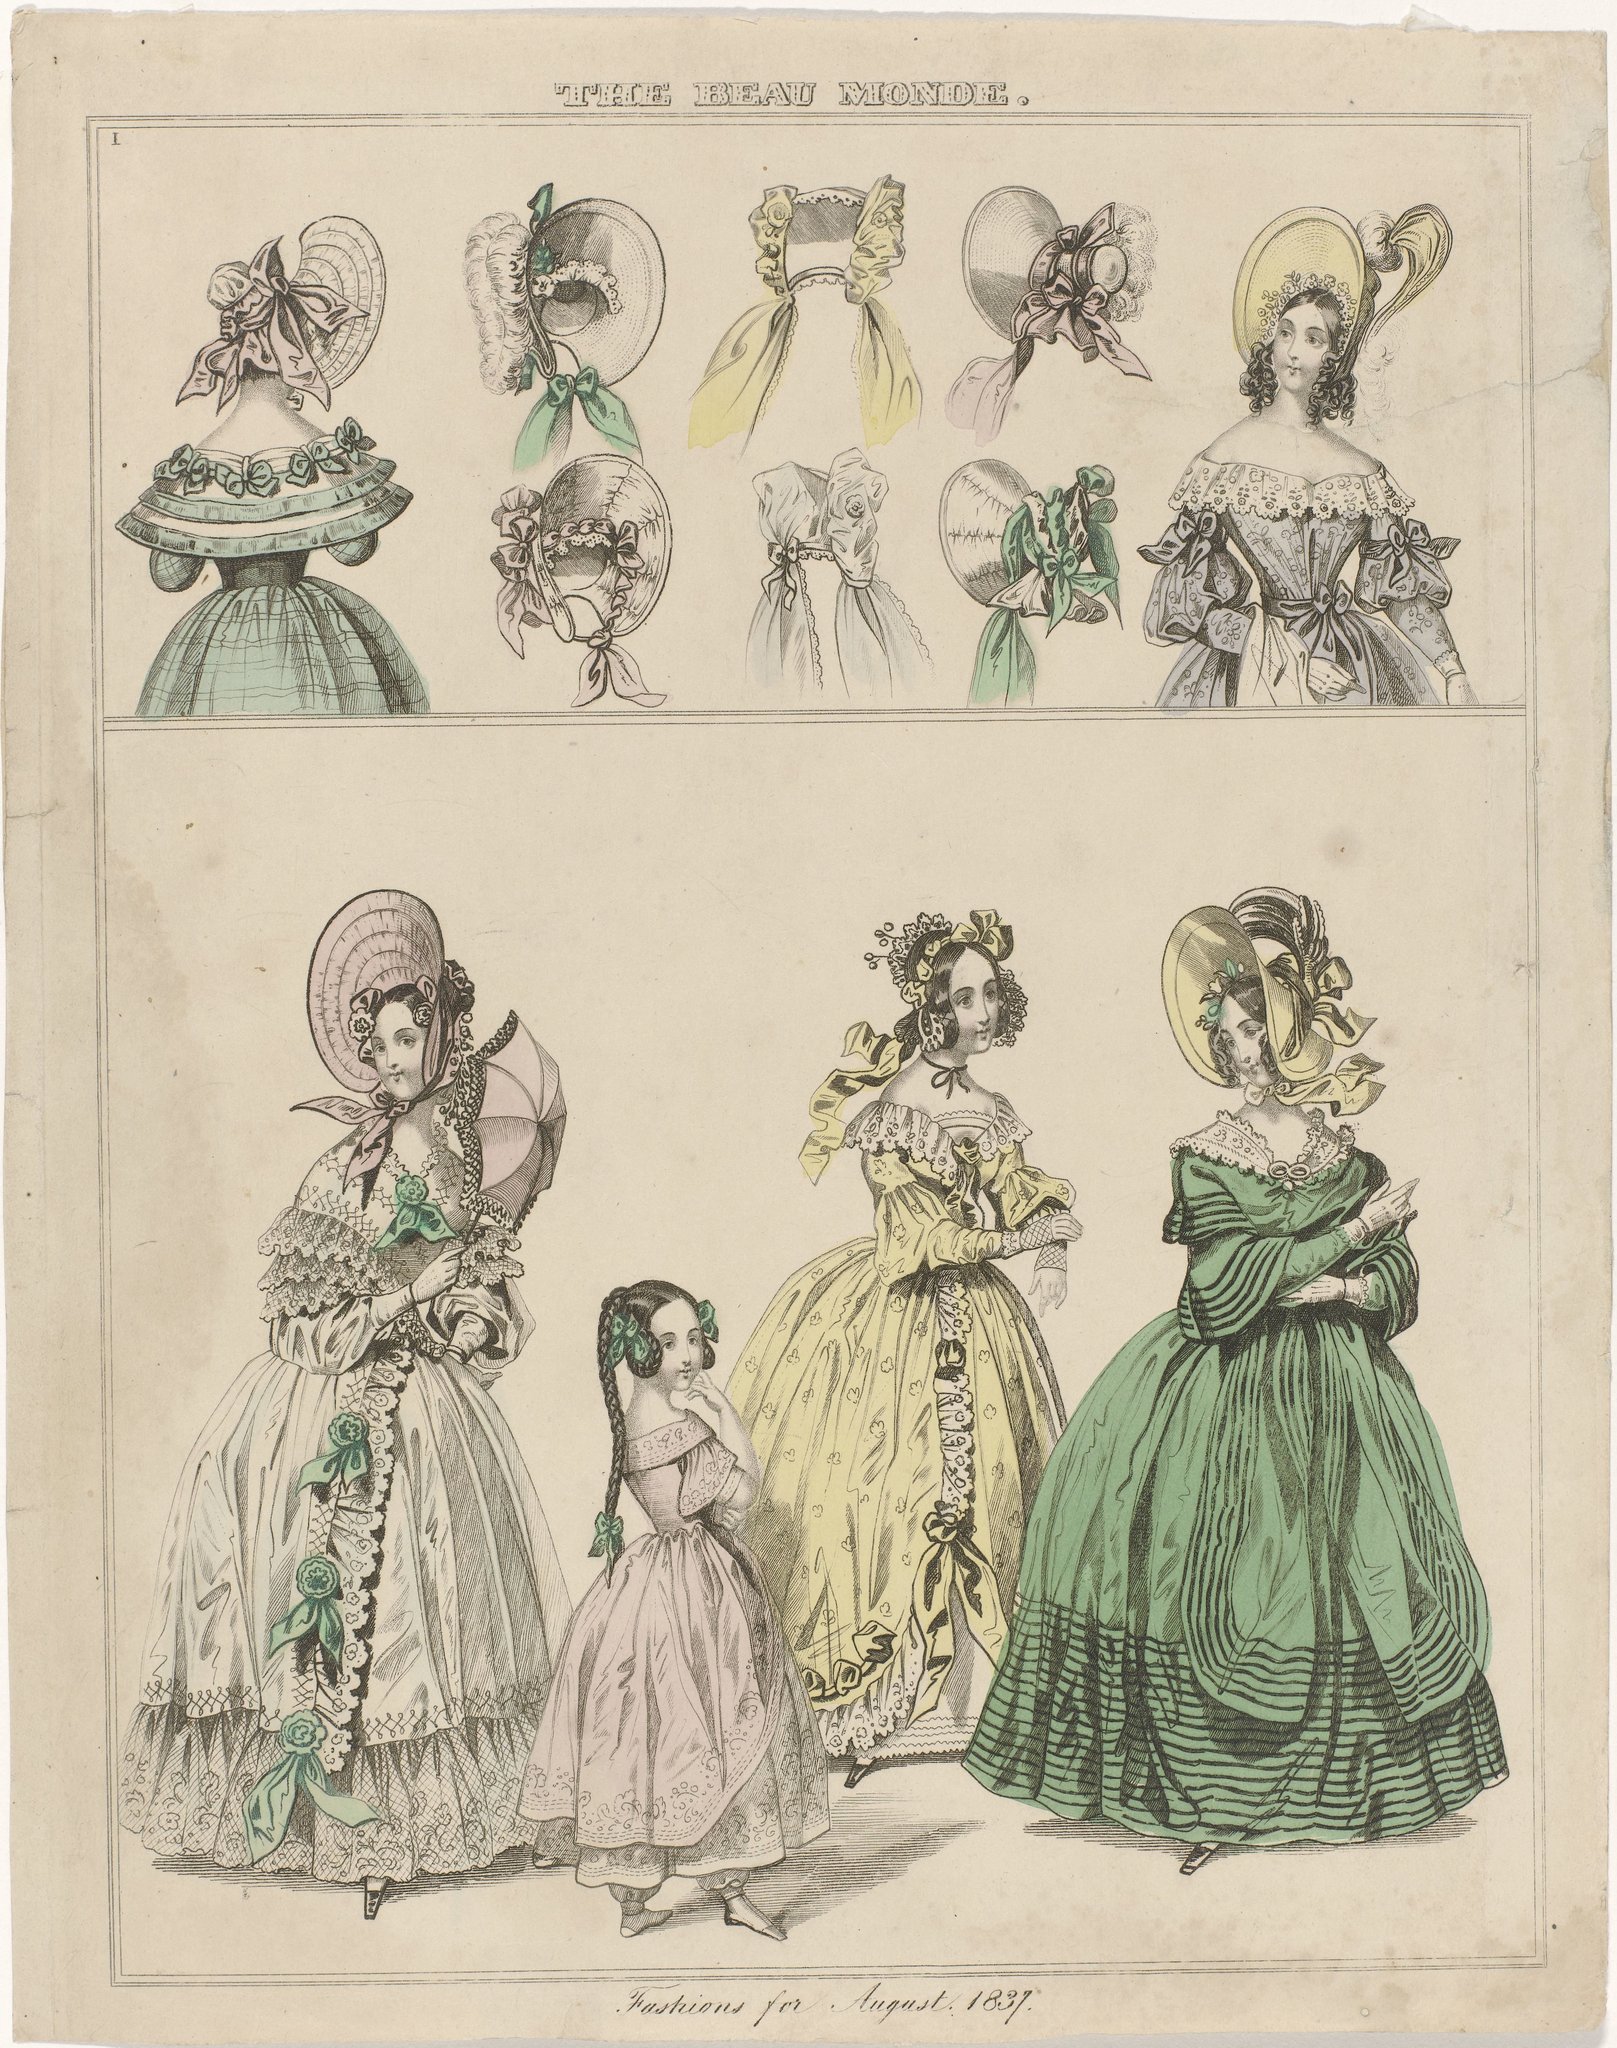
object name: fashion print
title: The Beau Monde, Fashions for August 1837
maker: Anonymous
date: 1837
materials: paper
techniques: engraving, hand coloring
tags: parasol, sunshade (+ girls' clothes), head-gear: cap (+ women's clothes), fashion plates, head-gear: hat (+ women's clothes), dress, gown (+ women's clothes), dress, gown (+ girls' clothes)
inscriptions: title: ‘THE BEAU MONDE.’, caption: ‘Fashions for August 1837’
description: In het bovenste kader zes luifelhoeden en twee mutsen. In het onderste kader drie vrouwen en een meisje in verschillende japonnen. Parasol met gekanteld blad. Volgens het onderschrift zijn dit de modes voor augustus 1837.